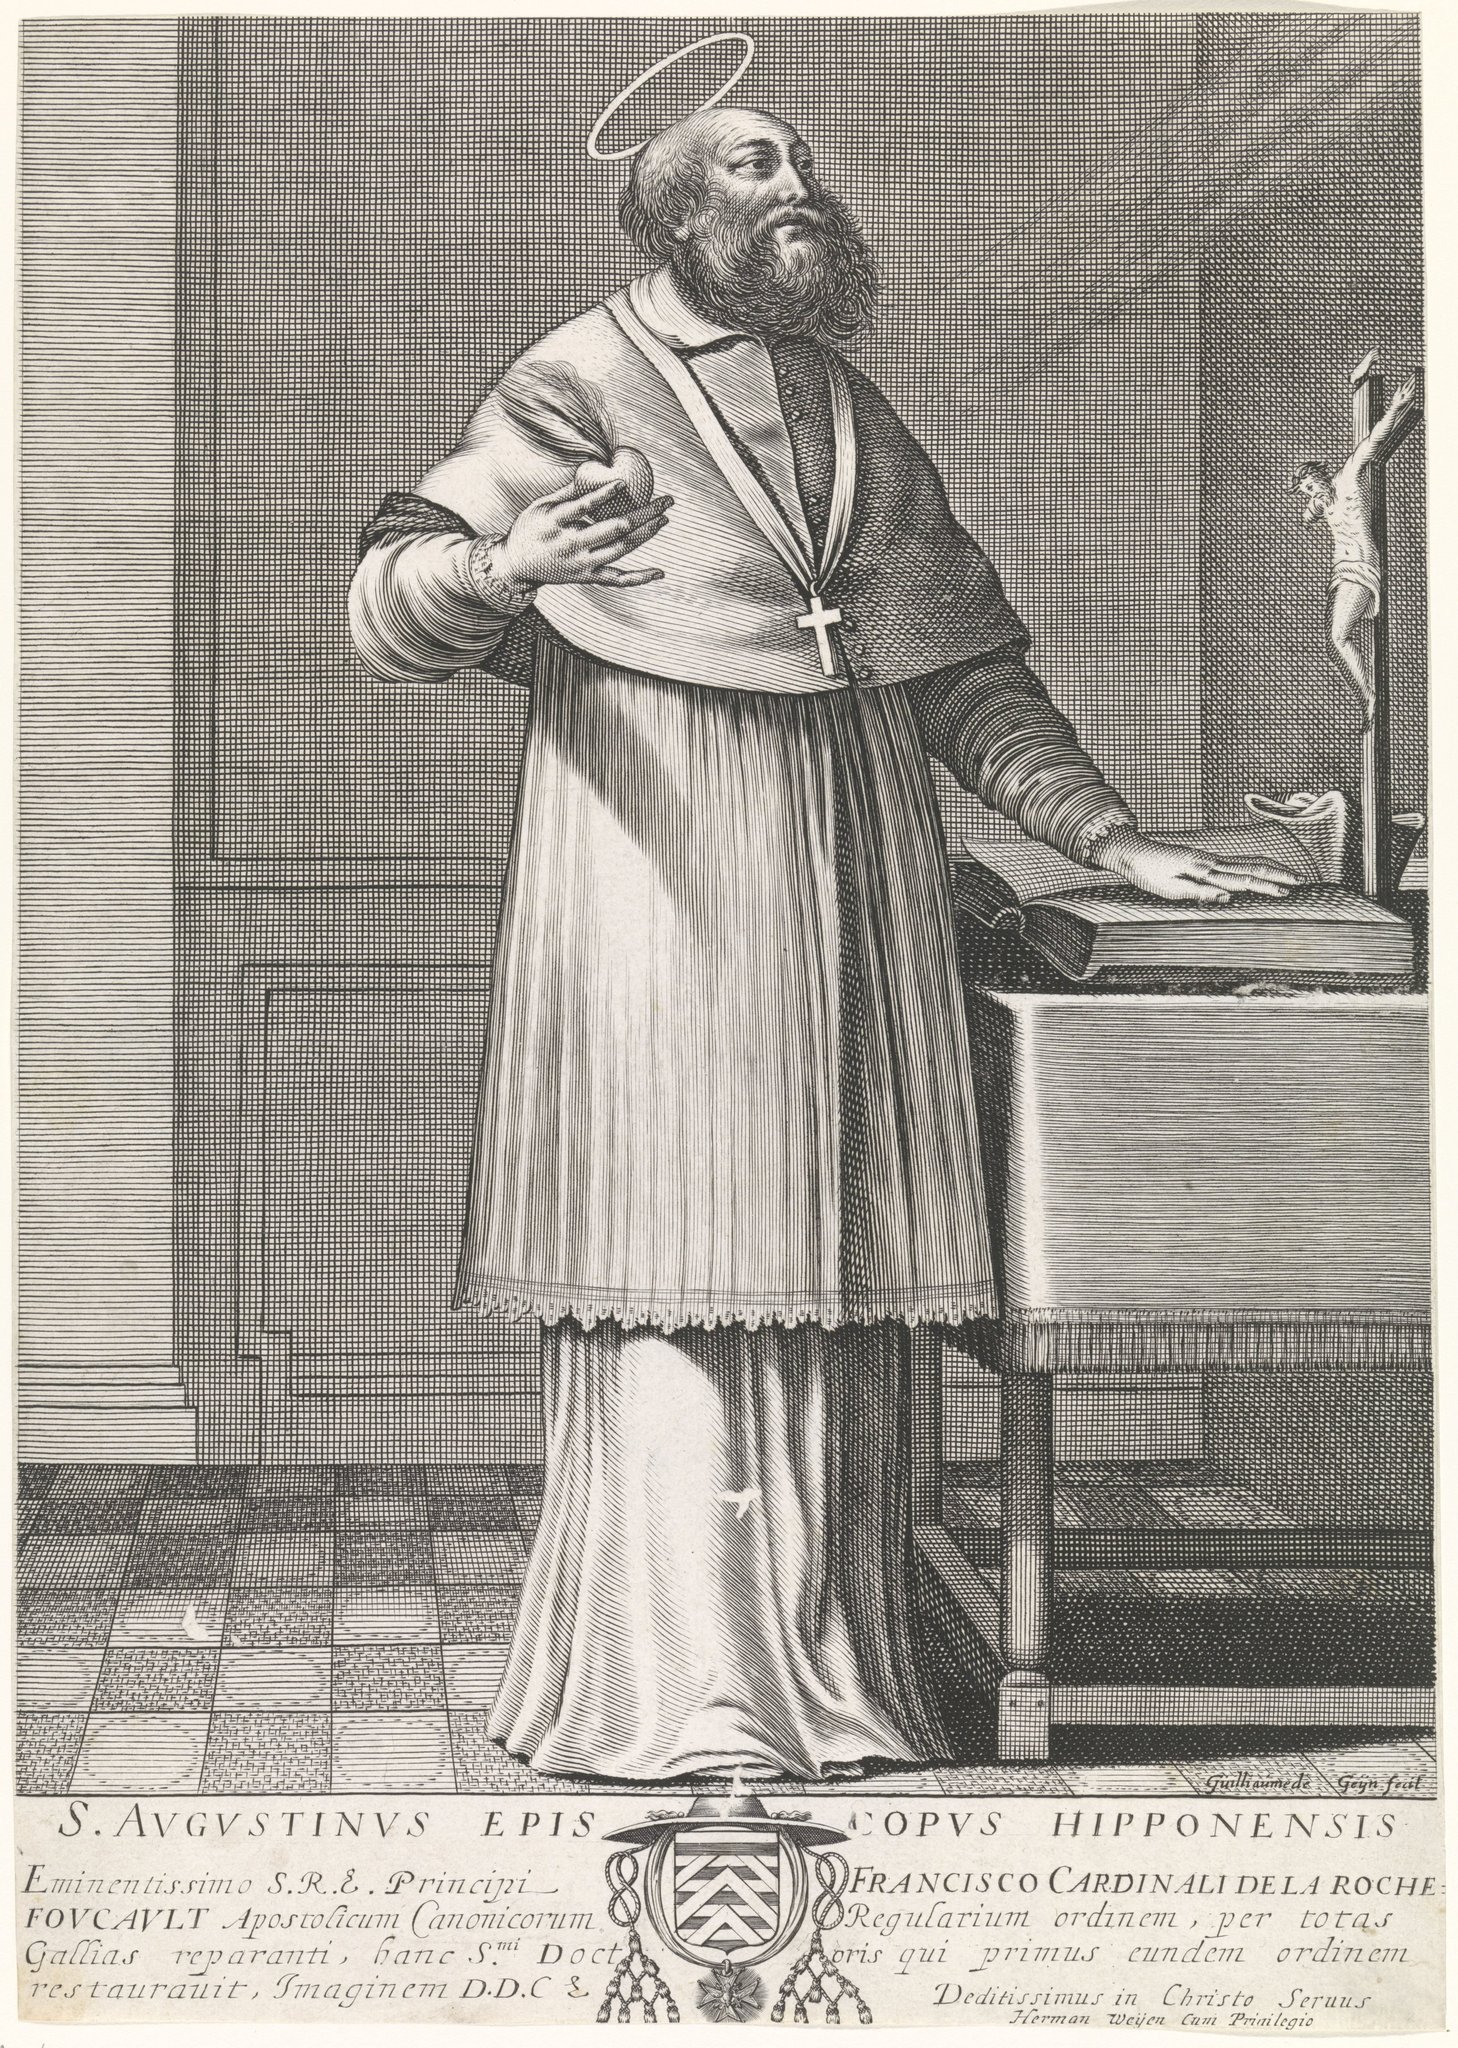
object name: print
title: Heilige Augustinus van Hippo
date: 1620-1650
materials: paper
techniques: engraving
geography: paris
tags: personal devotion of st. augustine - male saint meditating, in ecstasy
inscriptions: collector's mark: Lugt 2228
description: De kerkvader, de heilige Augustinus van Hippo. Hij staat voor een tafel met een bijbel en een kruisbeeld en houdt een brandend hart in zijn hand. De prent heeft een Latijns onderschrift.